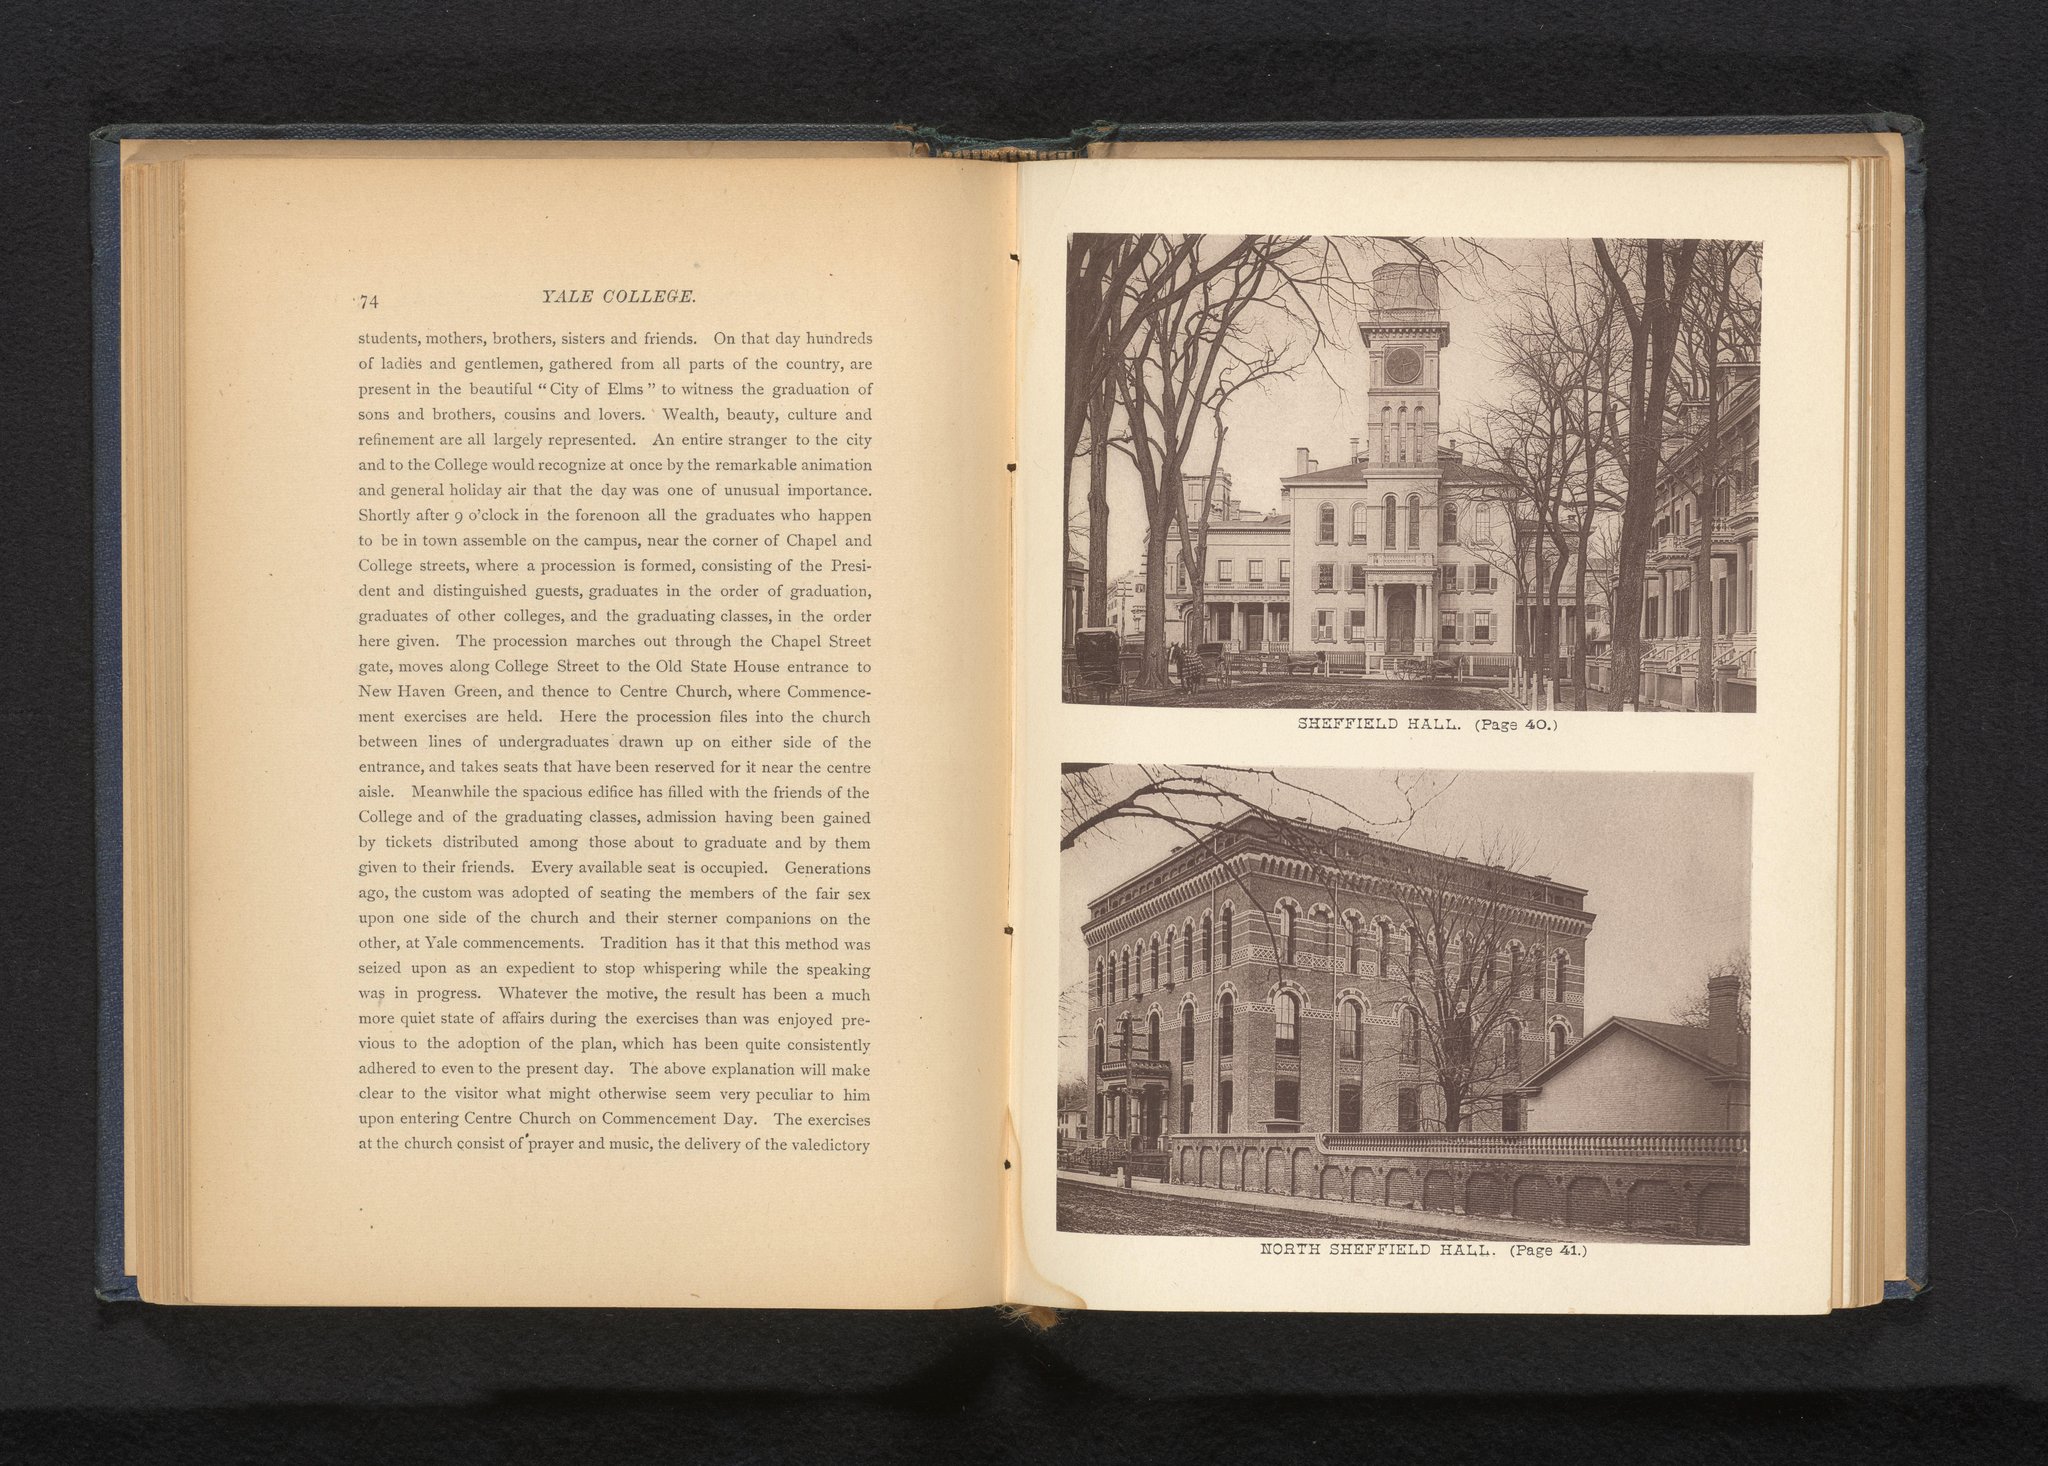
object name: photomechanical print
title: North Sheffield Hall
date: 1872-1882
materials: paper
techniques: photograph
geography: new haven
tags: university, façade (of house or building)